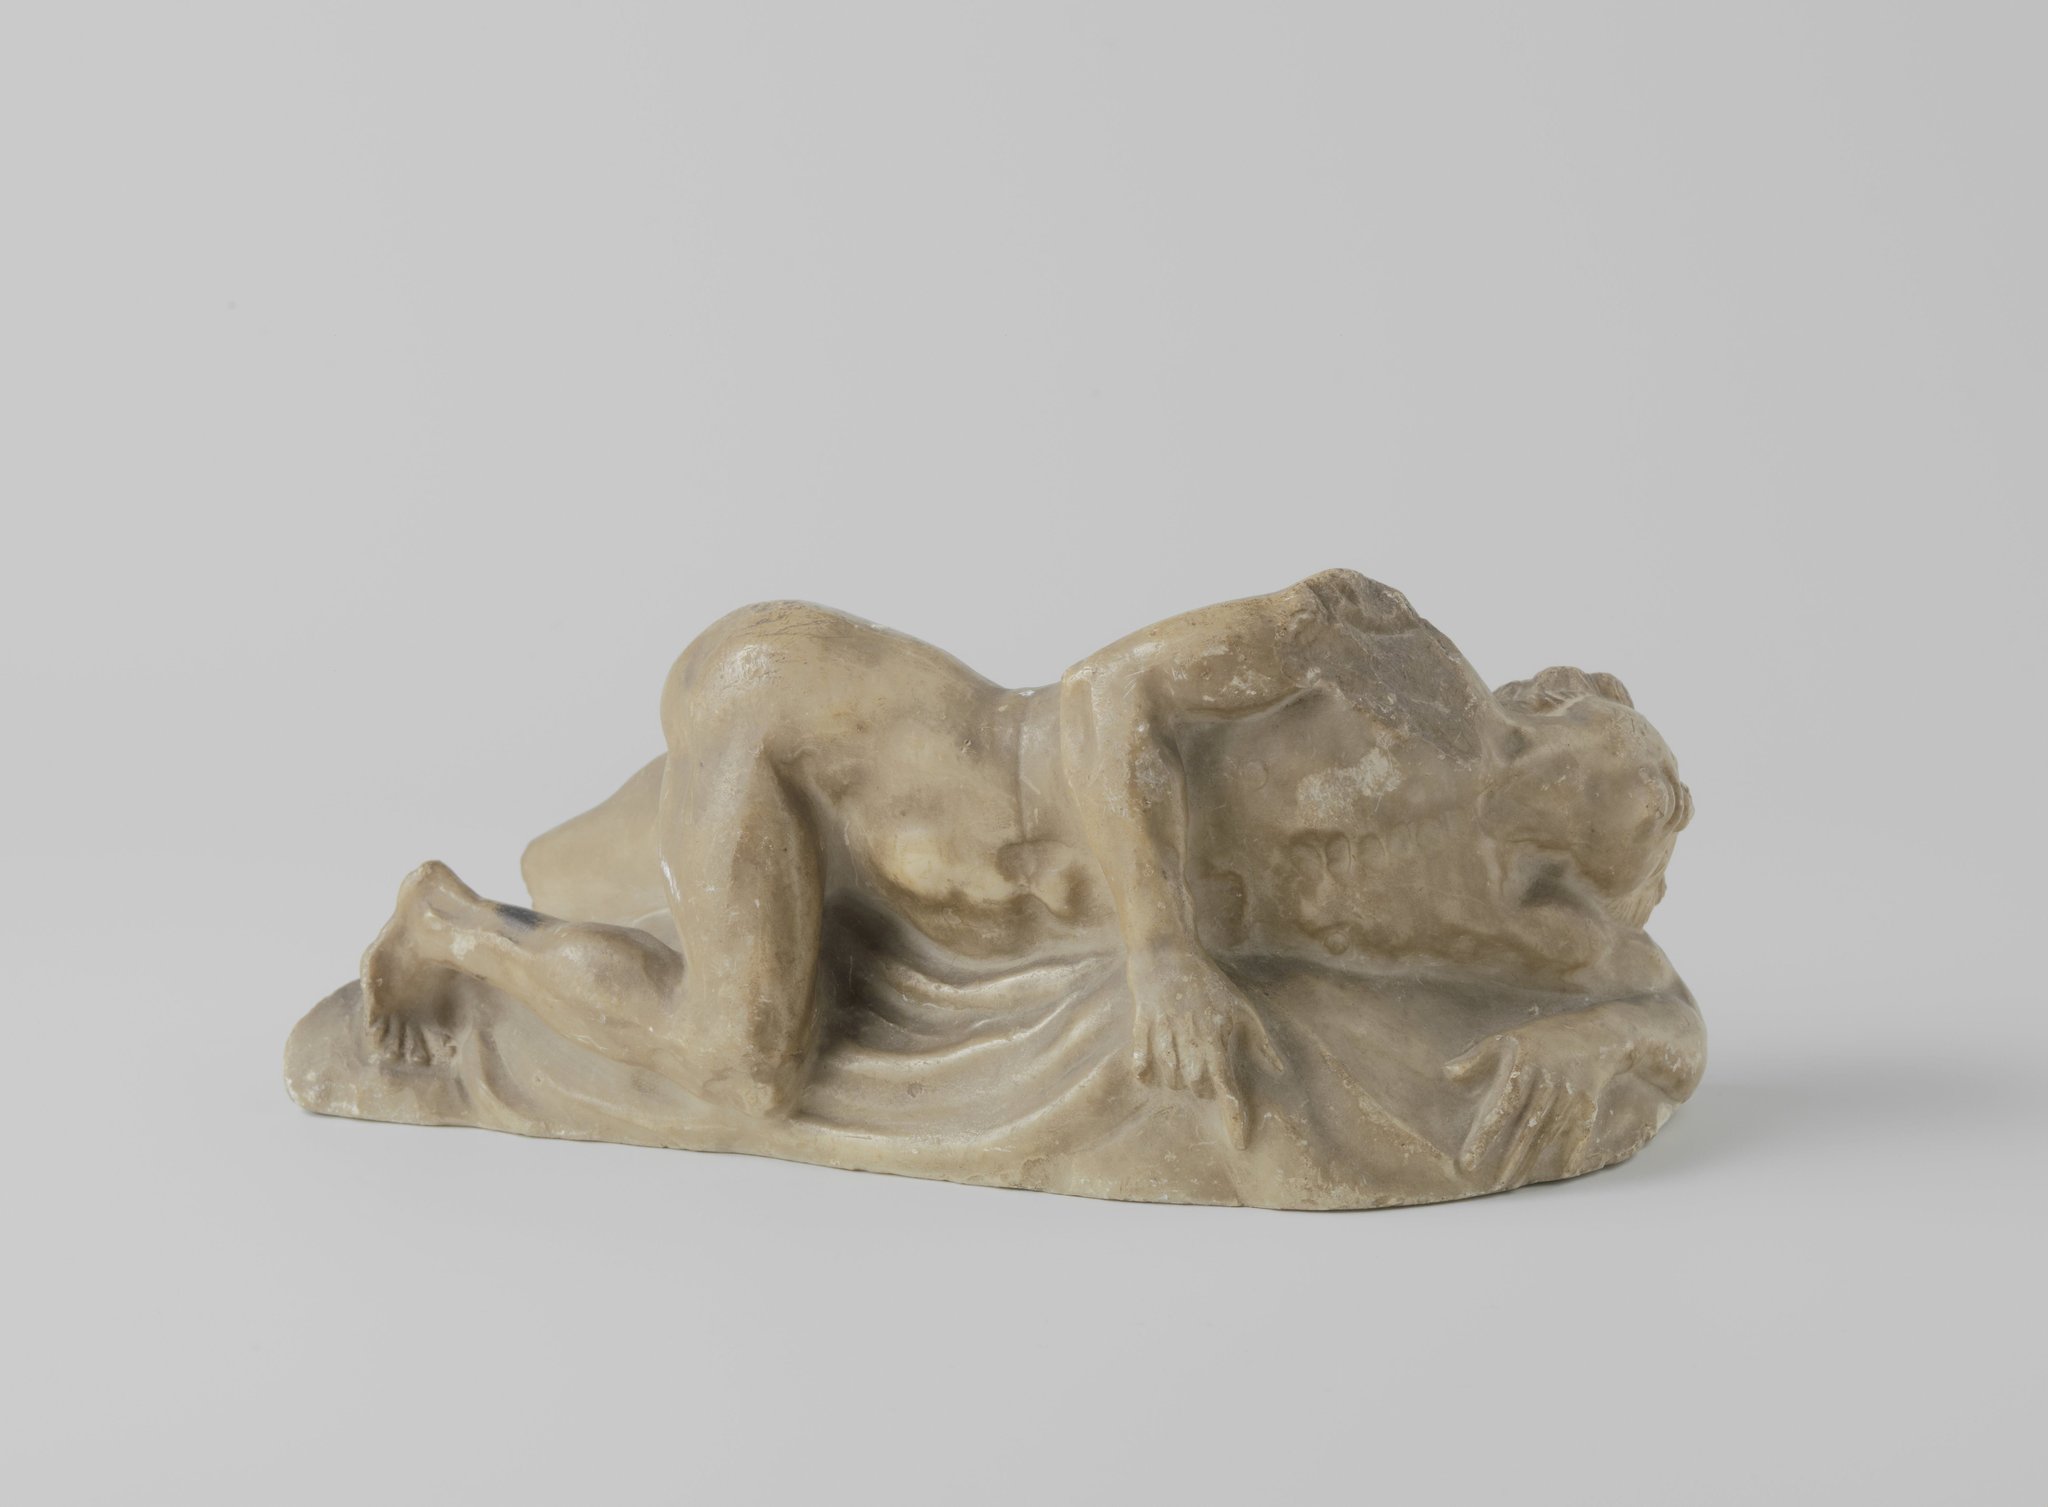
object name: sculpture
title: Naakte mannenfiguur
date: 1600-1699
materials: marble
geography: italy